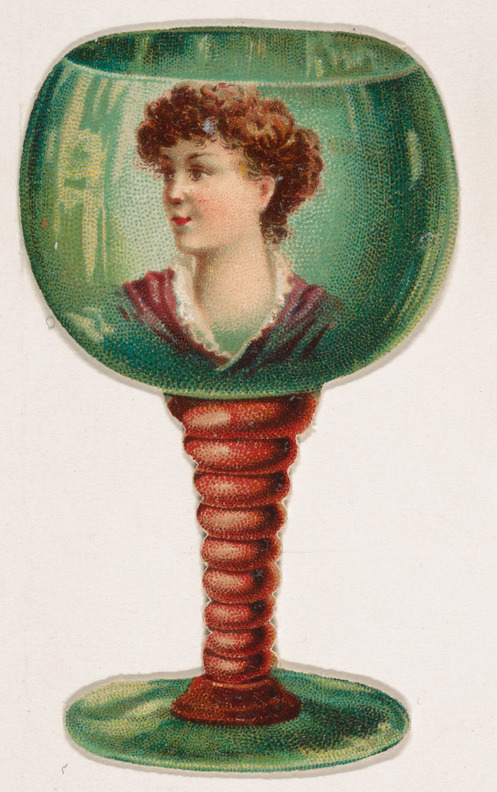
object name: print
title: Goblet, from the Novelties series (N228, Type 3) issued by Kinney Bros.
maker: kinney brothers tobacco company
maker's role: publisher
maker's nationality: american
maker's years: 1869-2011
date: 1889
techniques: color lithograph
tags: women,drinking glasses